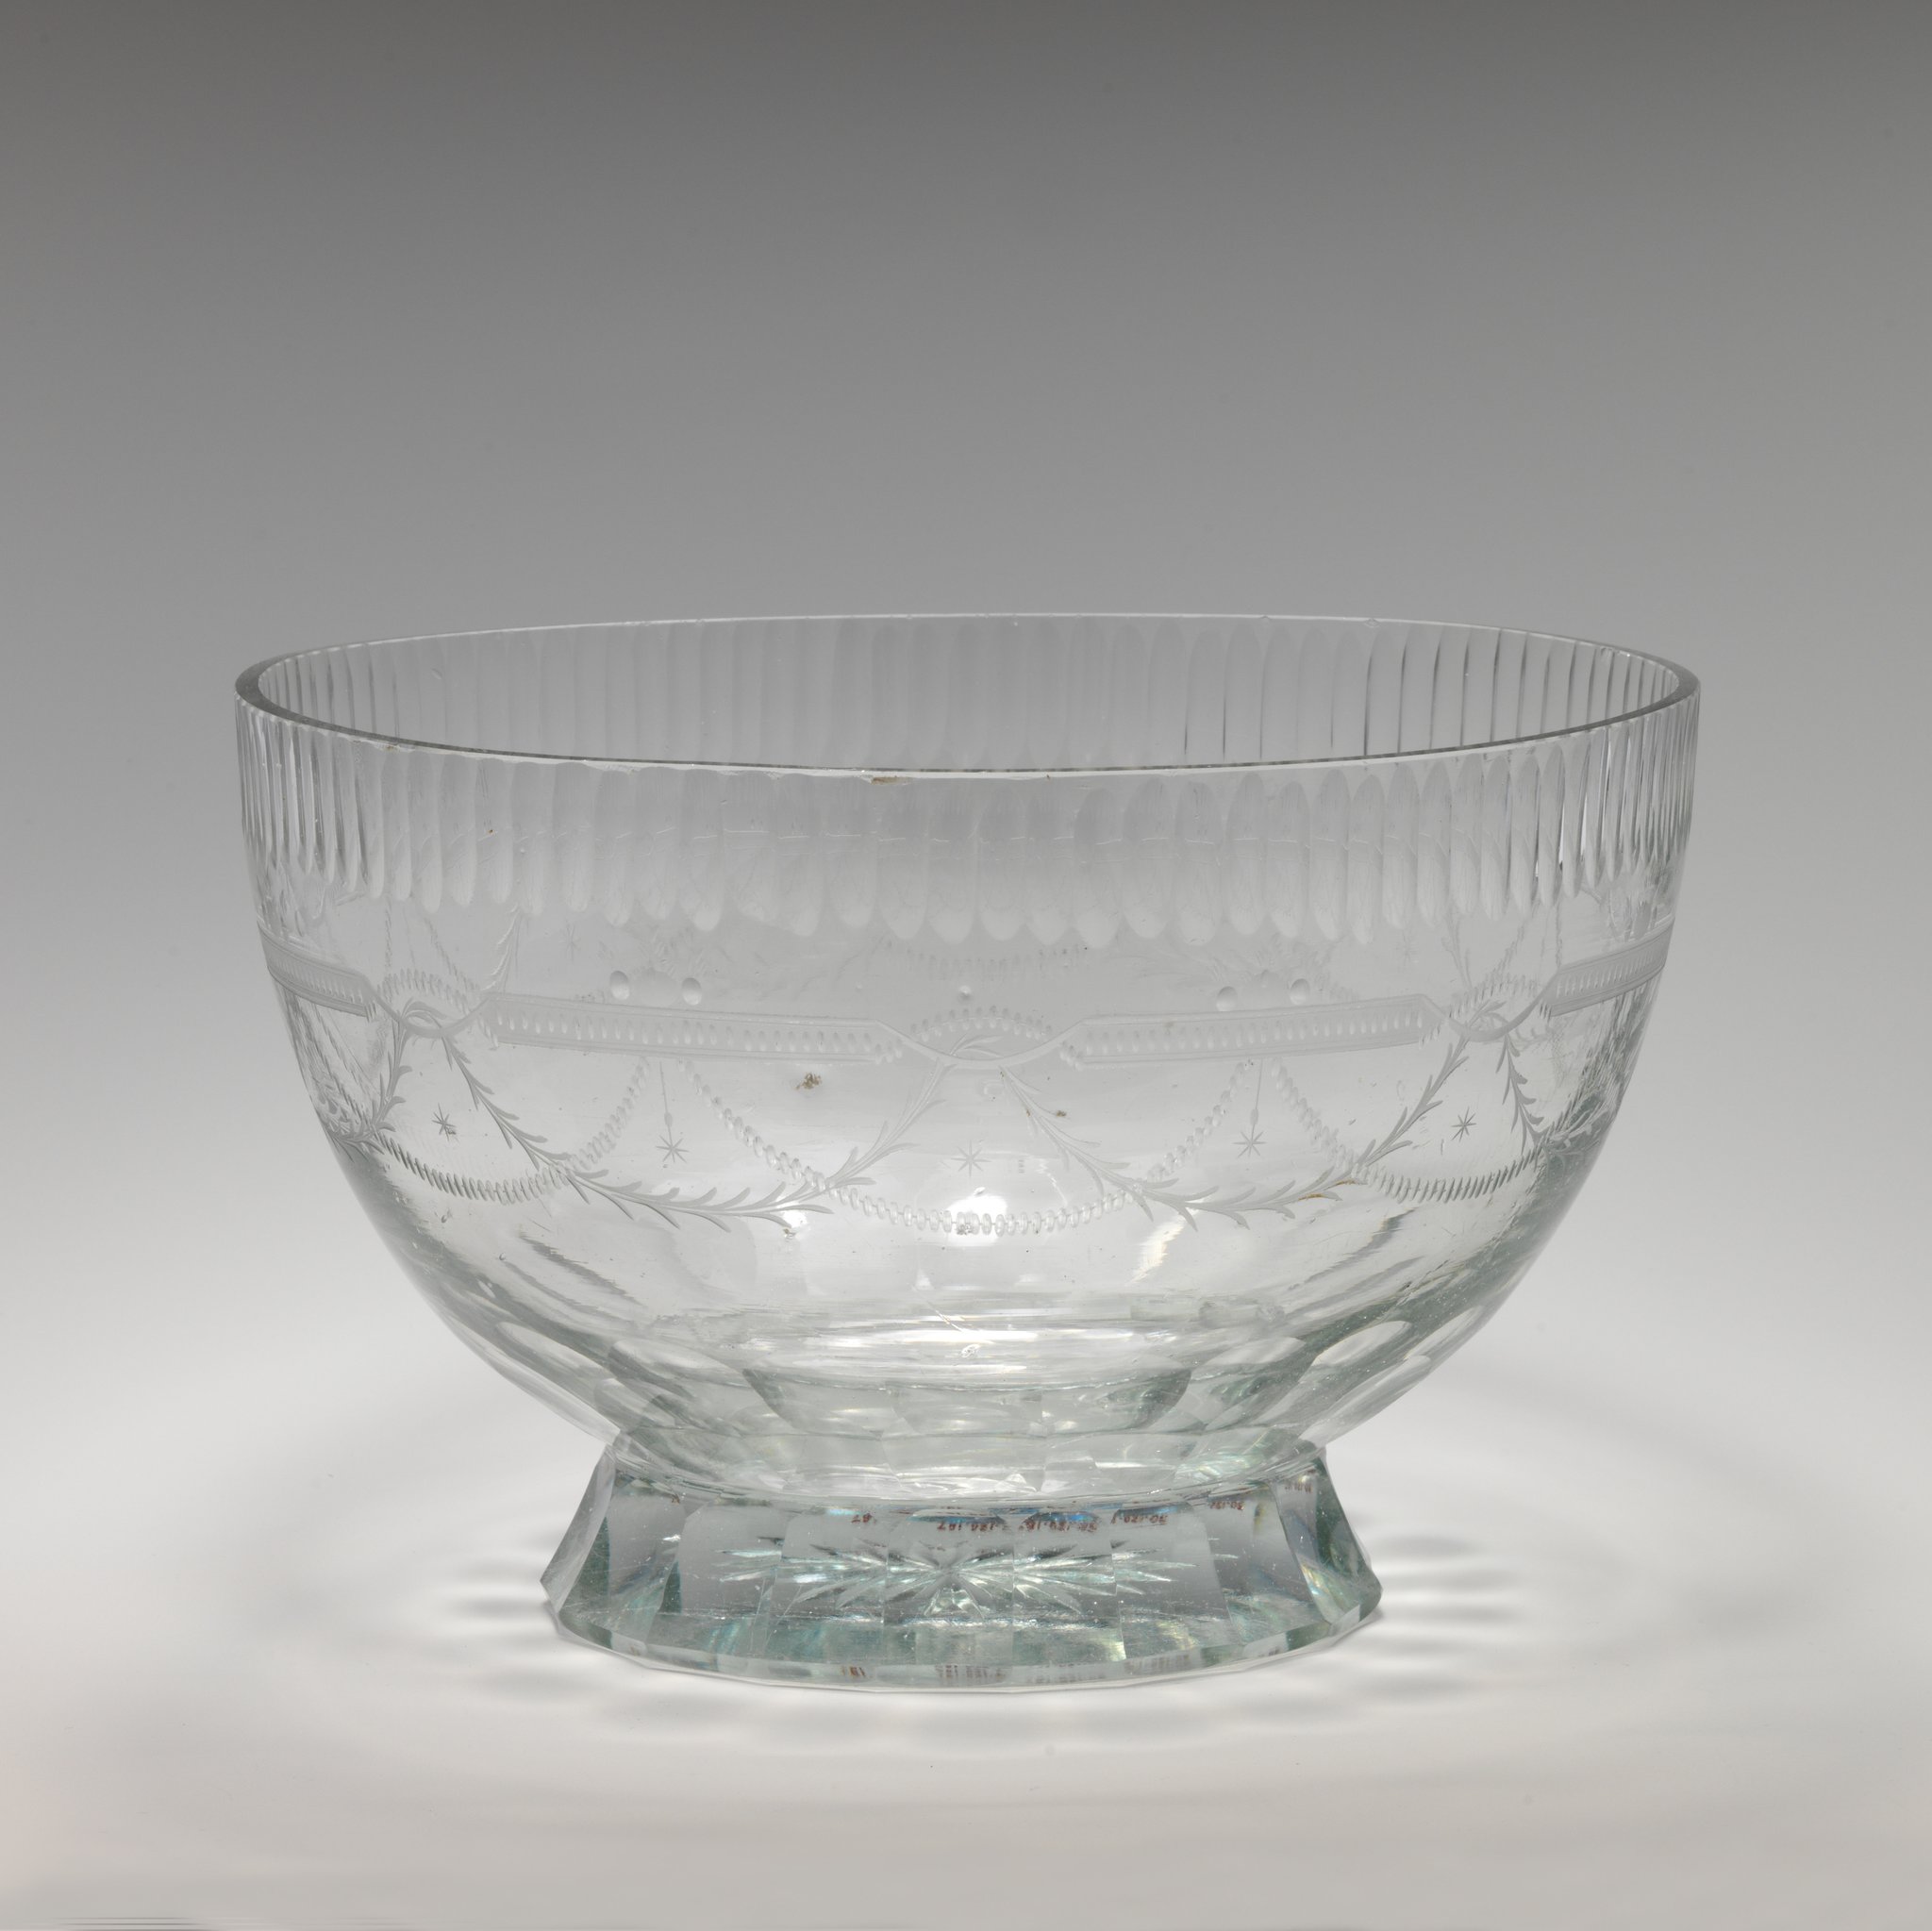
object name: bowl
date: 1767-1833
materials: glass